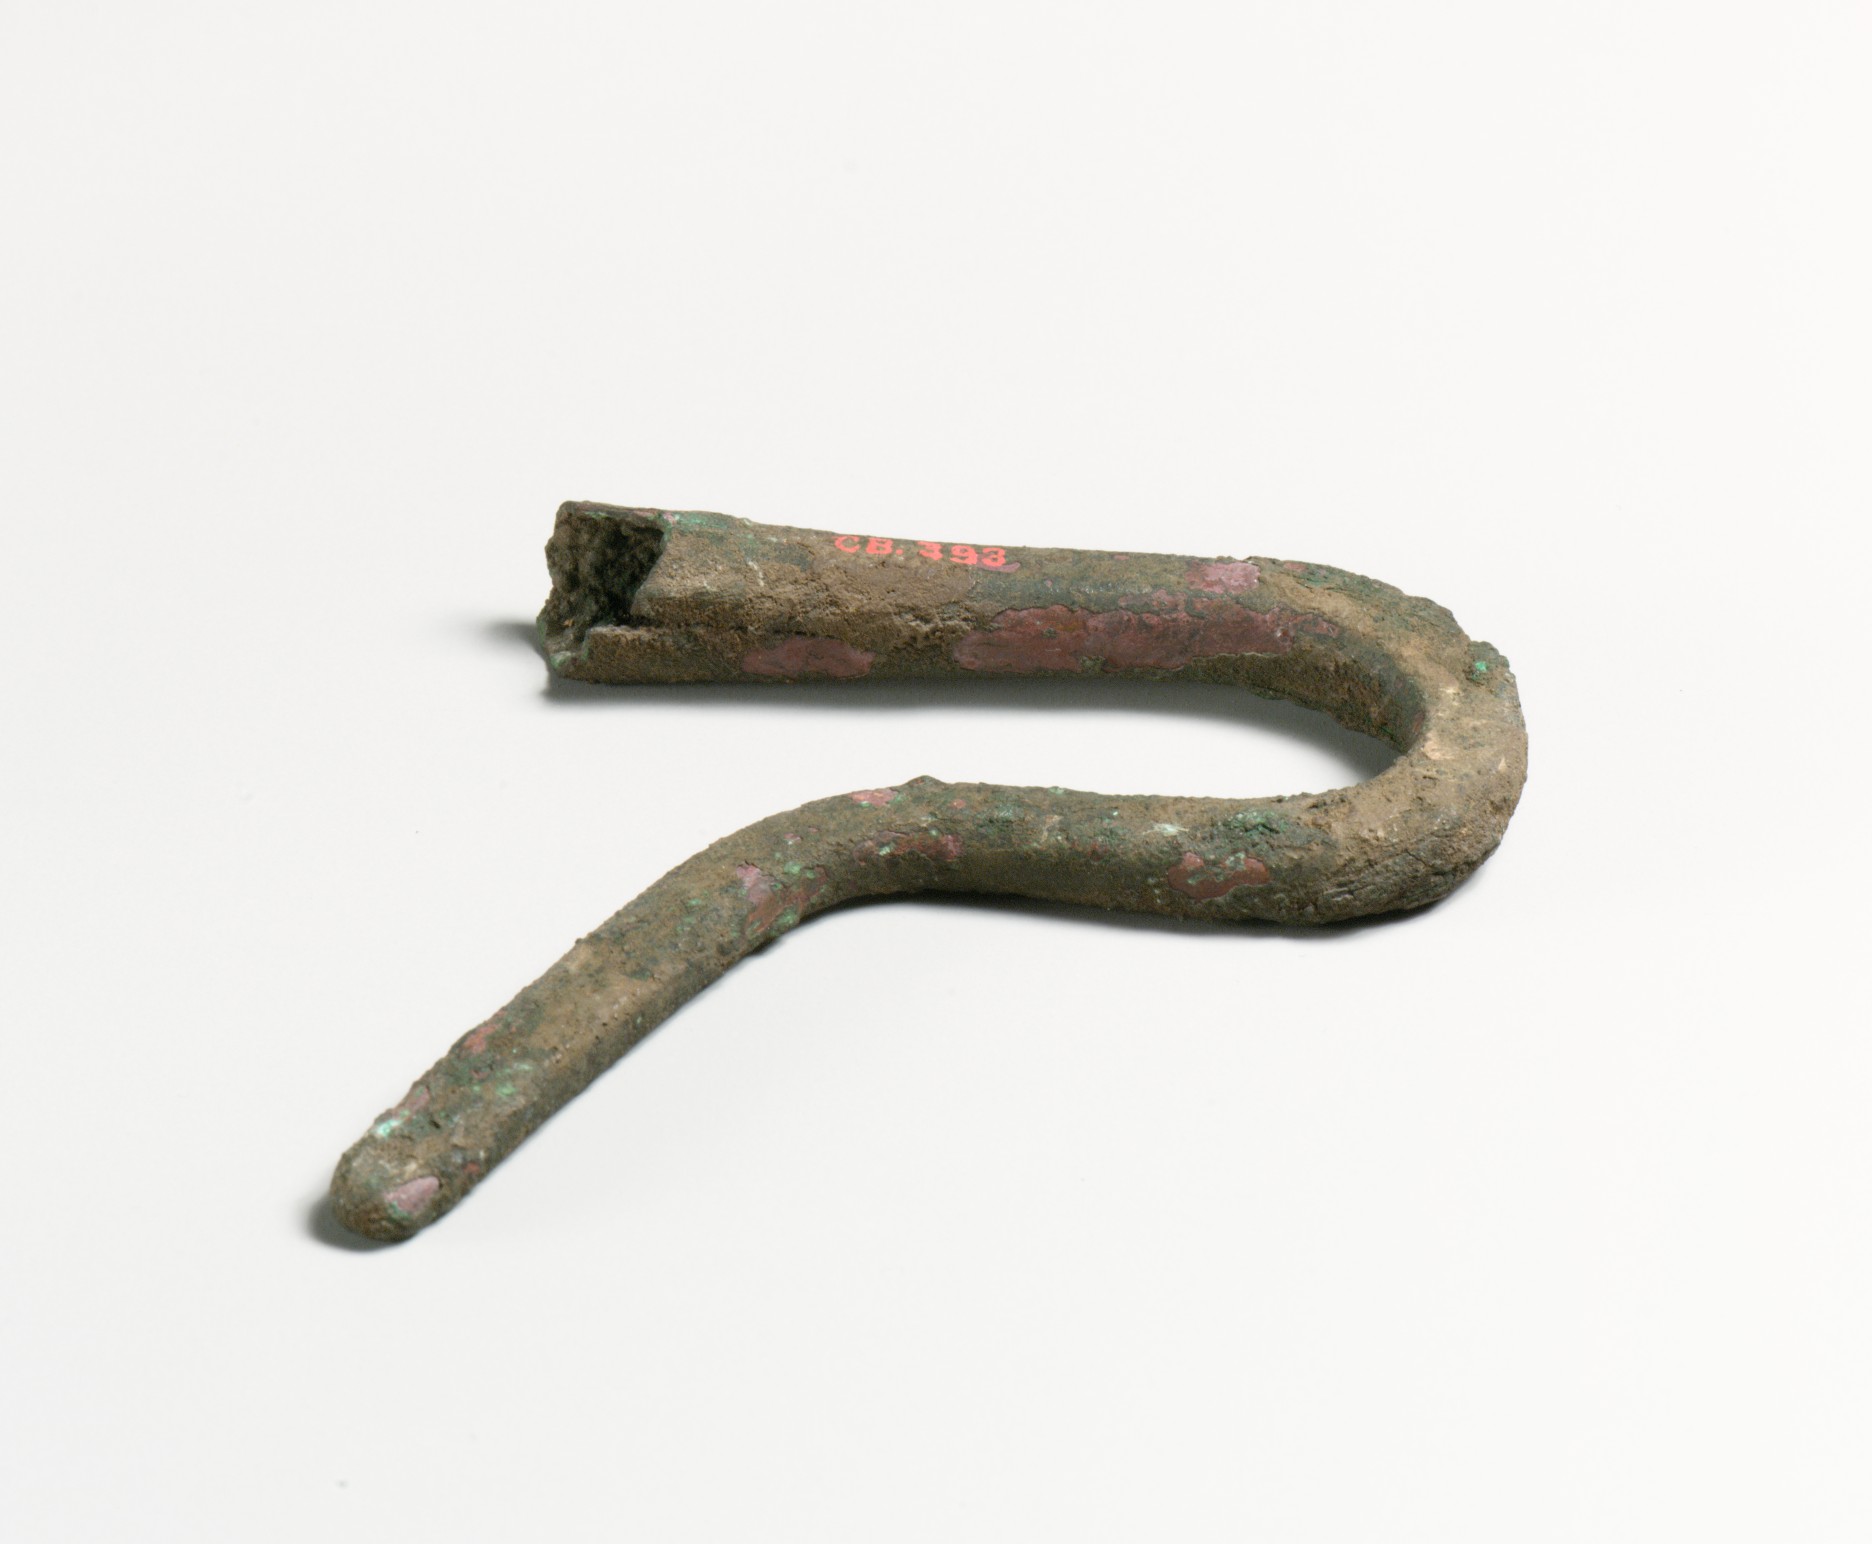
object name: shepherd's crook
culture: cypriot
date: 3900 BCE-100 CE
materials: bronze